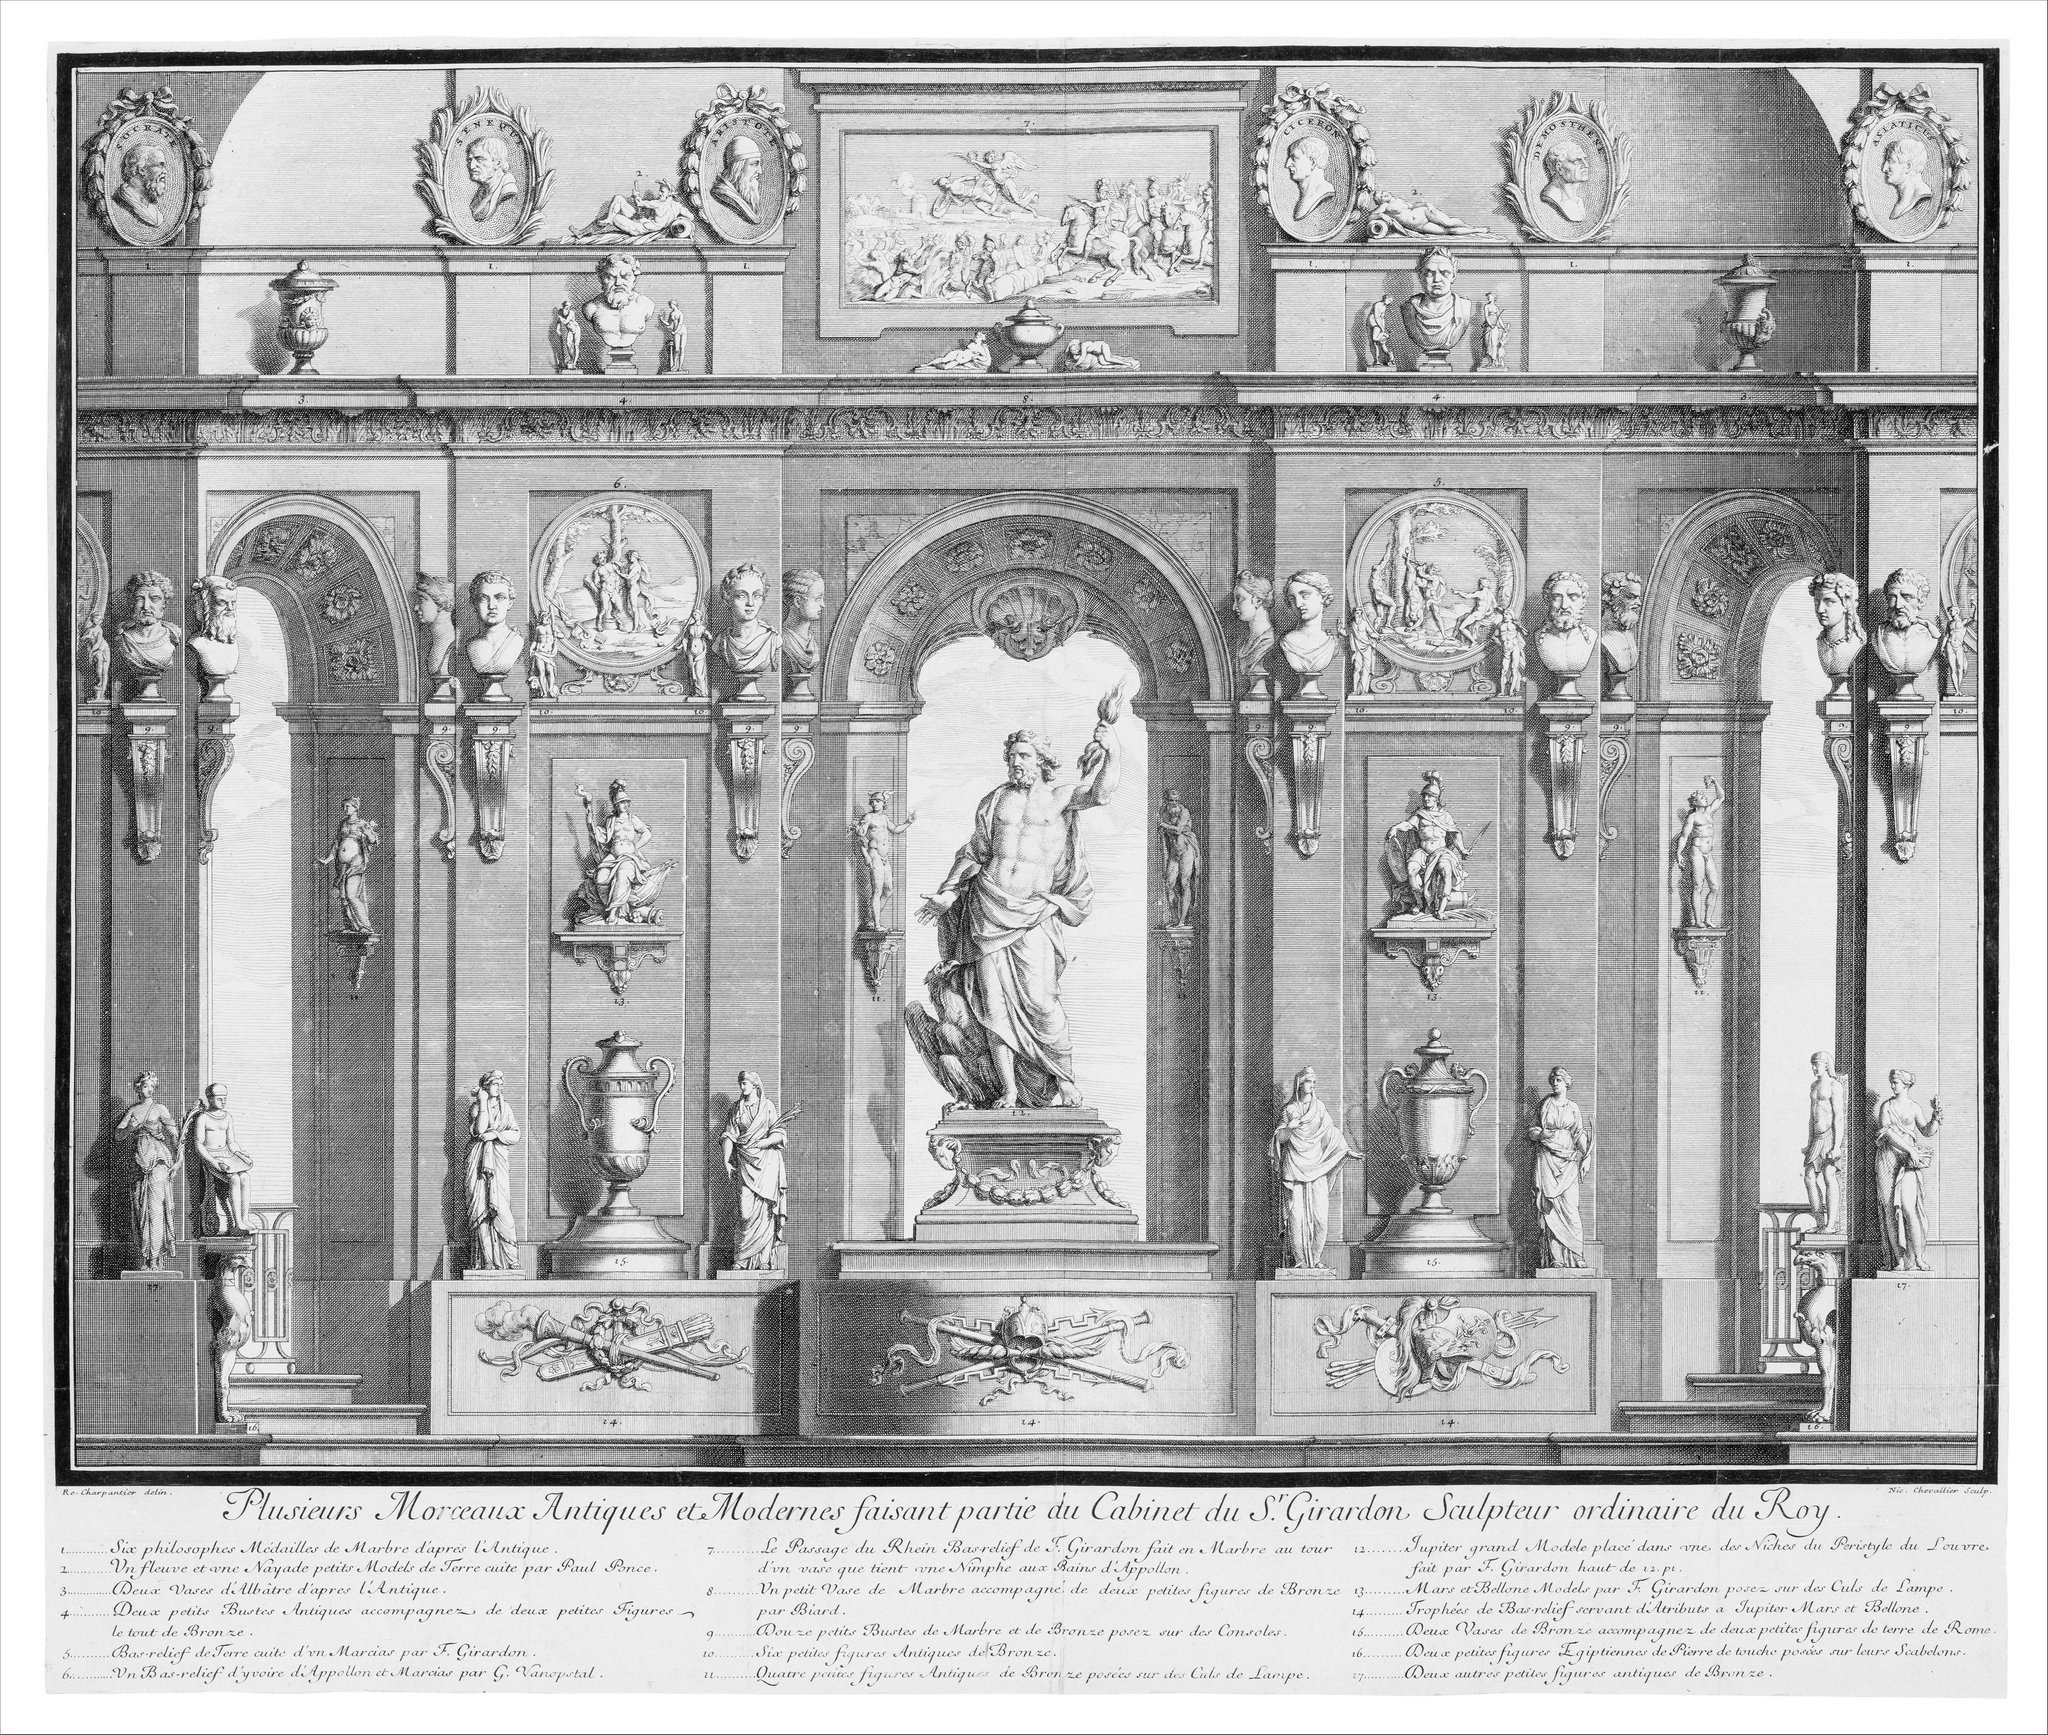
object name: print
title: La Galerie de Girardon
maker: nicolas chevalier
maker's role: artist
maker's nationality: french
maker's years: 1700-1800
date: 1701-1800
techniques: engraving, etching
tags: sculpture,architecture